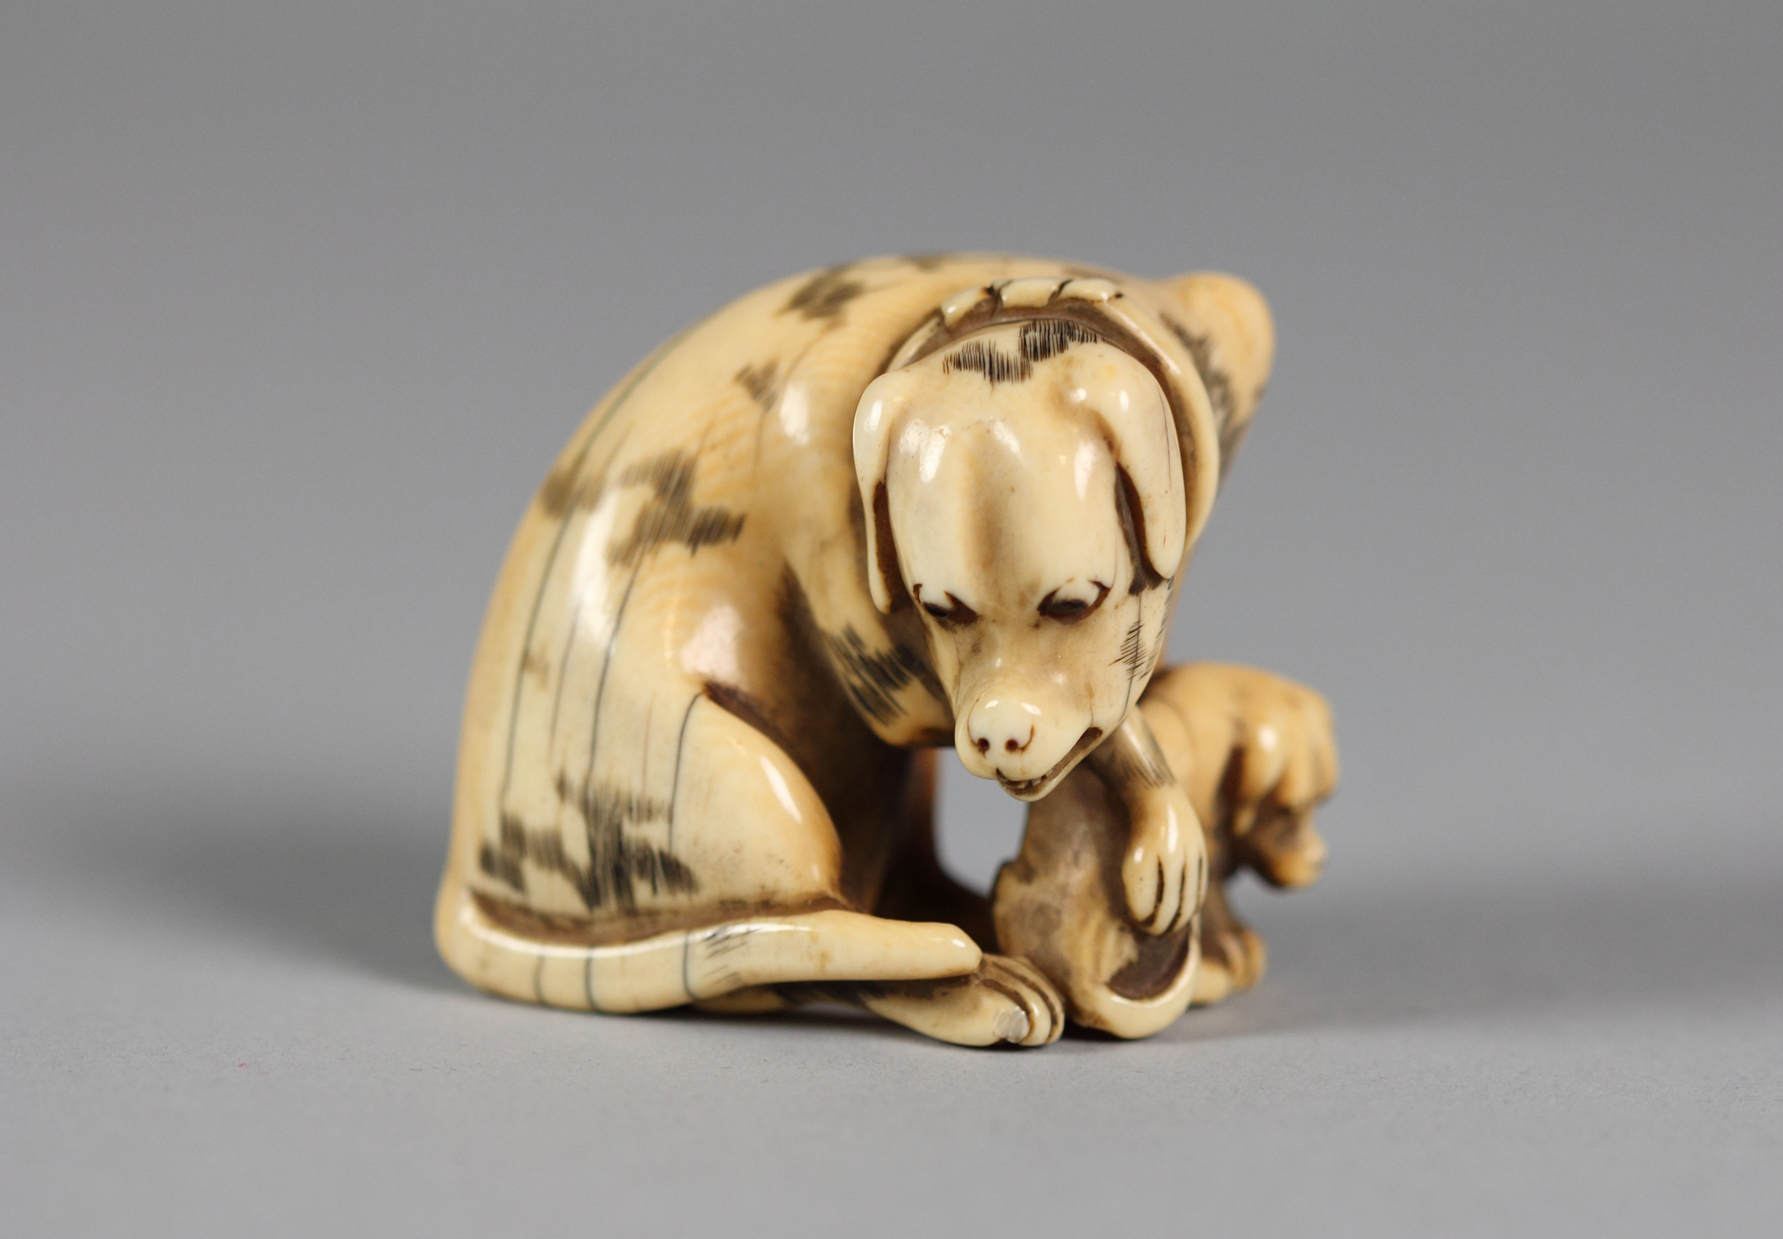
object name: netsuke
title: Netsuke of Dog and Puppy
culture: japanese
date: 1801-1900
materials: ivory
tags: dogs